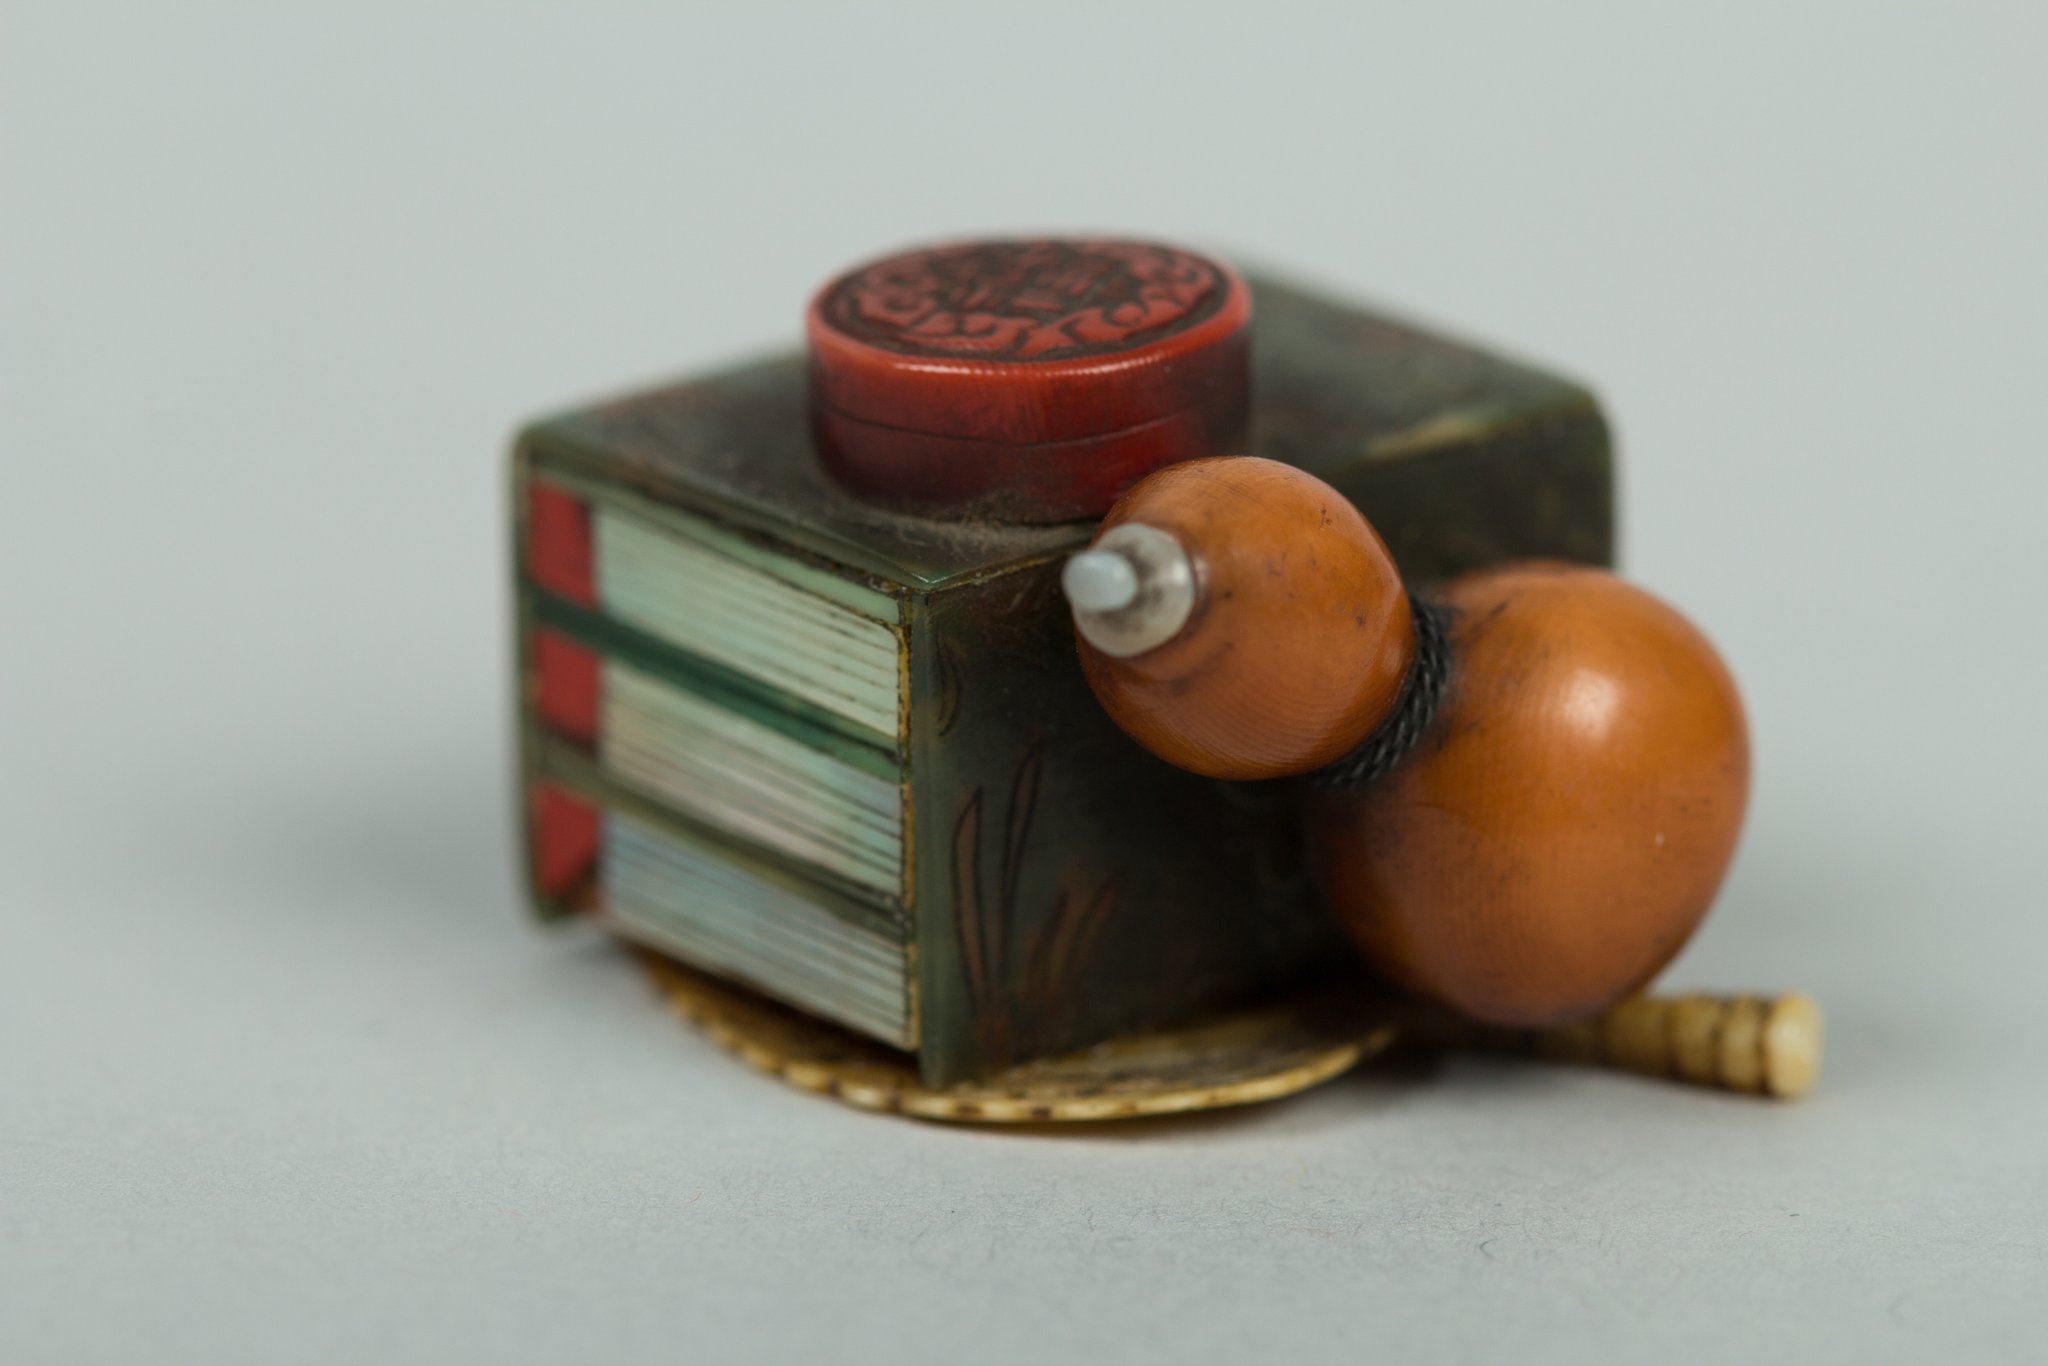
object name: netsuke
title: Netsuke of Books, a Gourd, Fan and Box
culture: japanese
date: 1701-1800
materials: ivory, jade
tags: fans